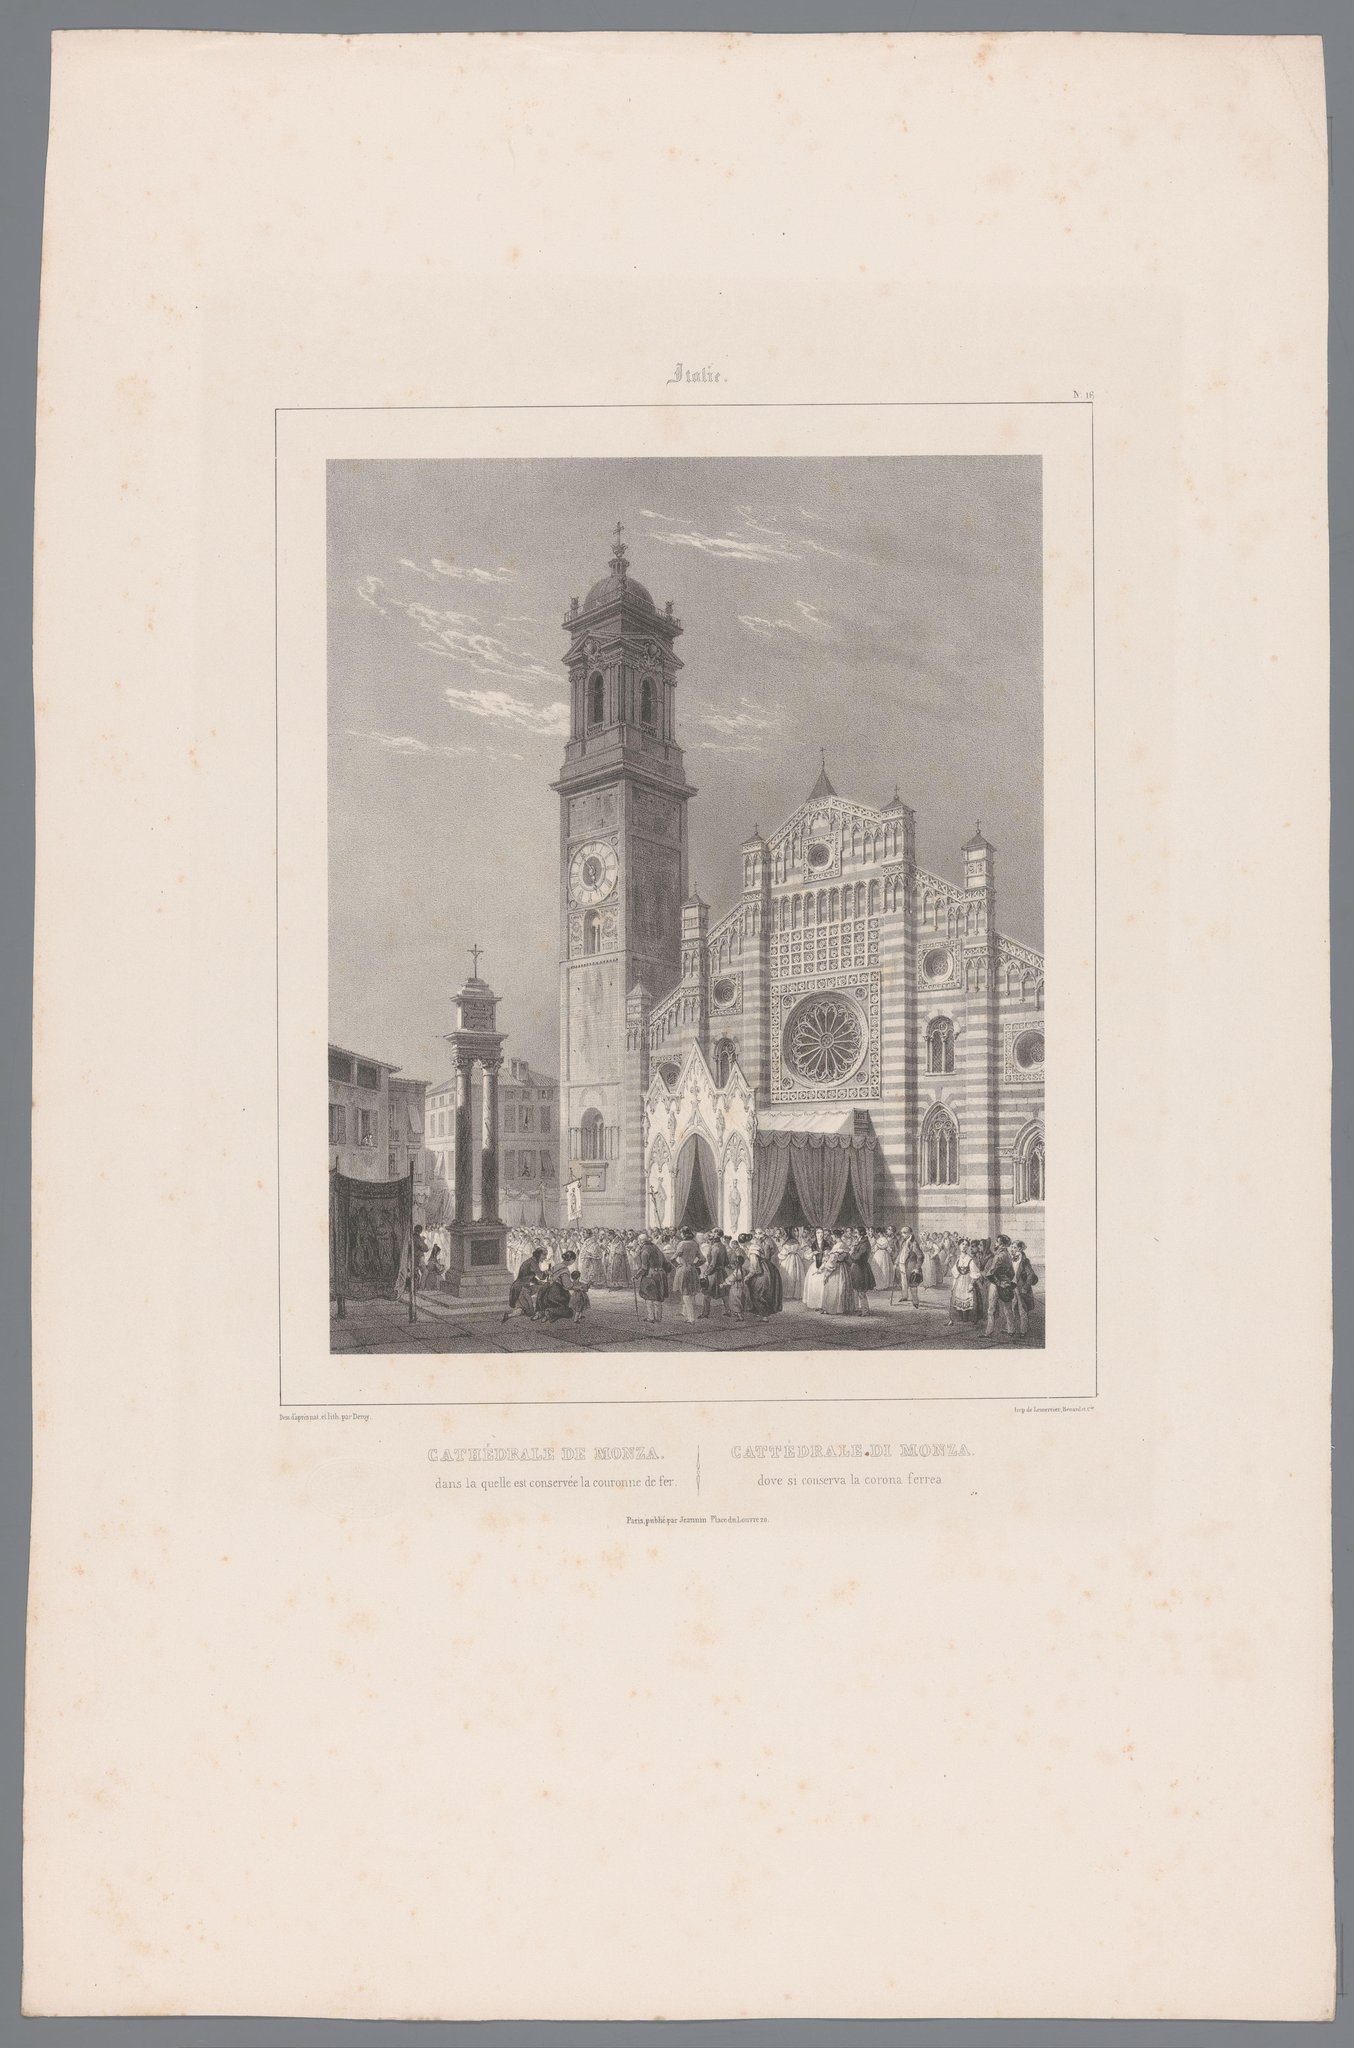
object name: print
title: Italie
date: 1838-1841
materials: paper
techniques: lithograph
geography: paris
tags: church (exterior), procession ~ christian religion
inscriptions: collector's mark: Lugt 2228a, check stamp: Lugt 1397c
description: Prent maakt deel uit van een omslag met zes prenten.